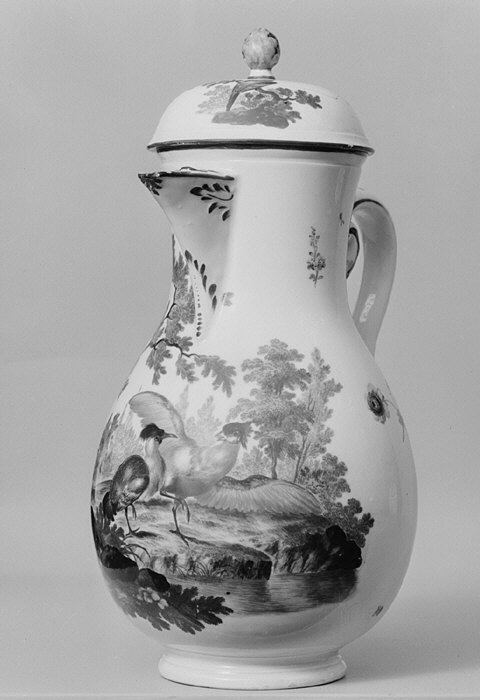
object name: coffeepot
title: Coffeepot (part of a service)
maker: frankenthal porcelain manufactory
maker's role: manufactory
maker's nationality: german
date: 1770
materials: hard paste porcelain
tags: birds,trees